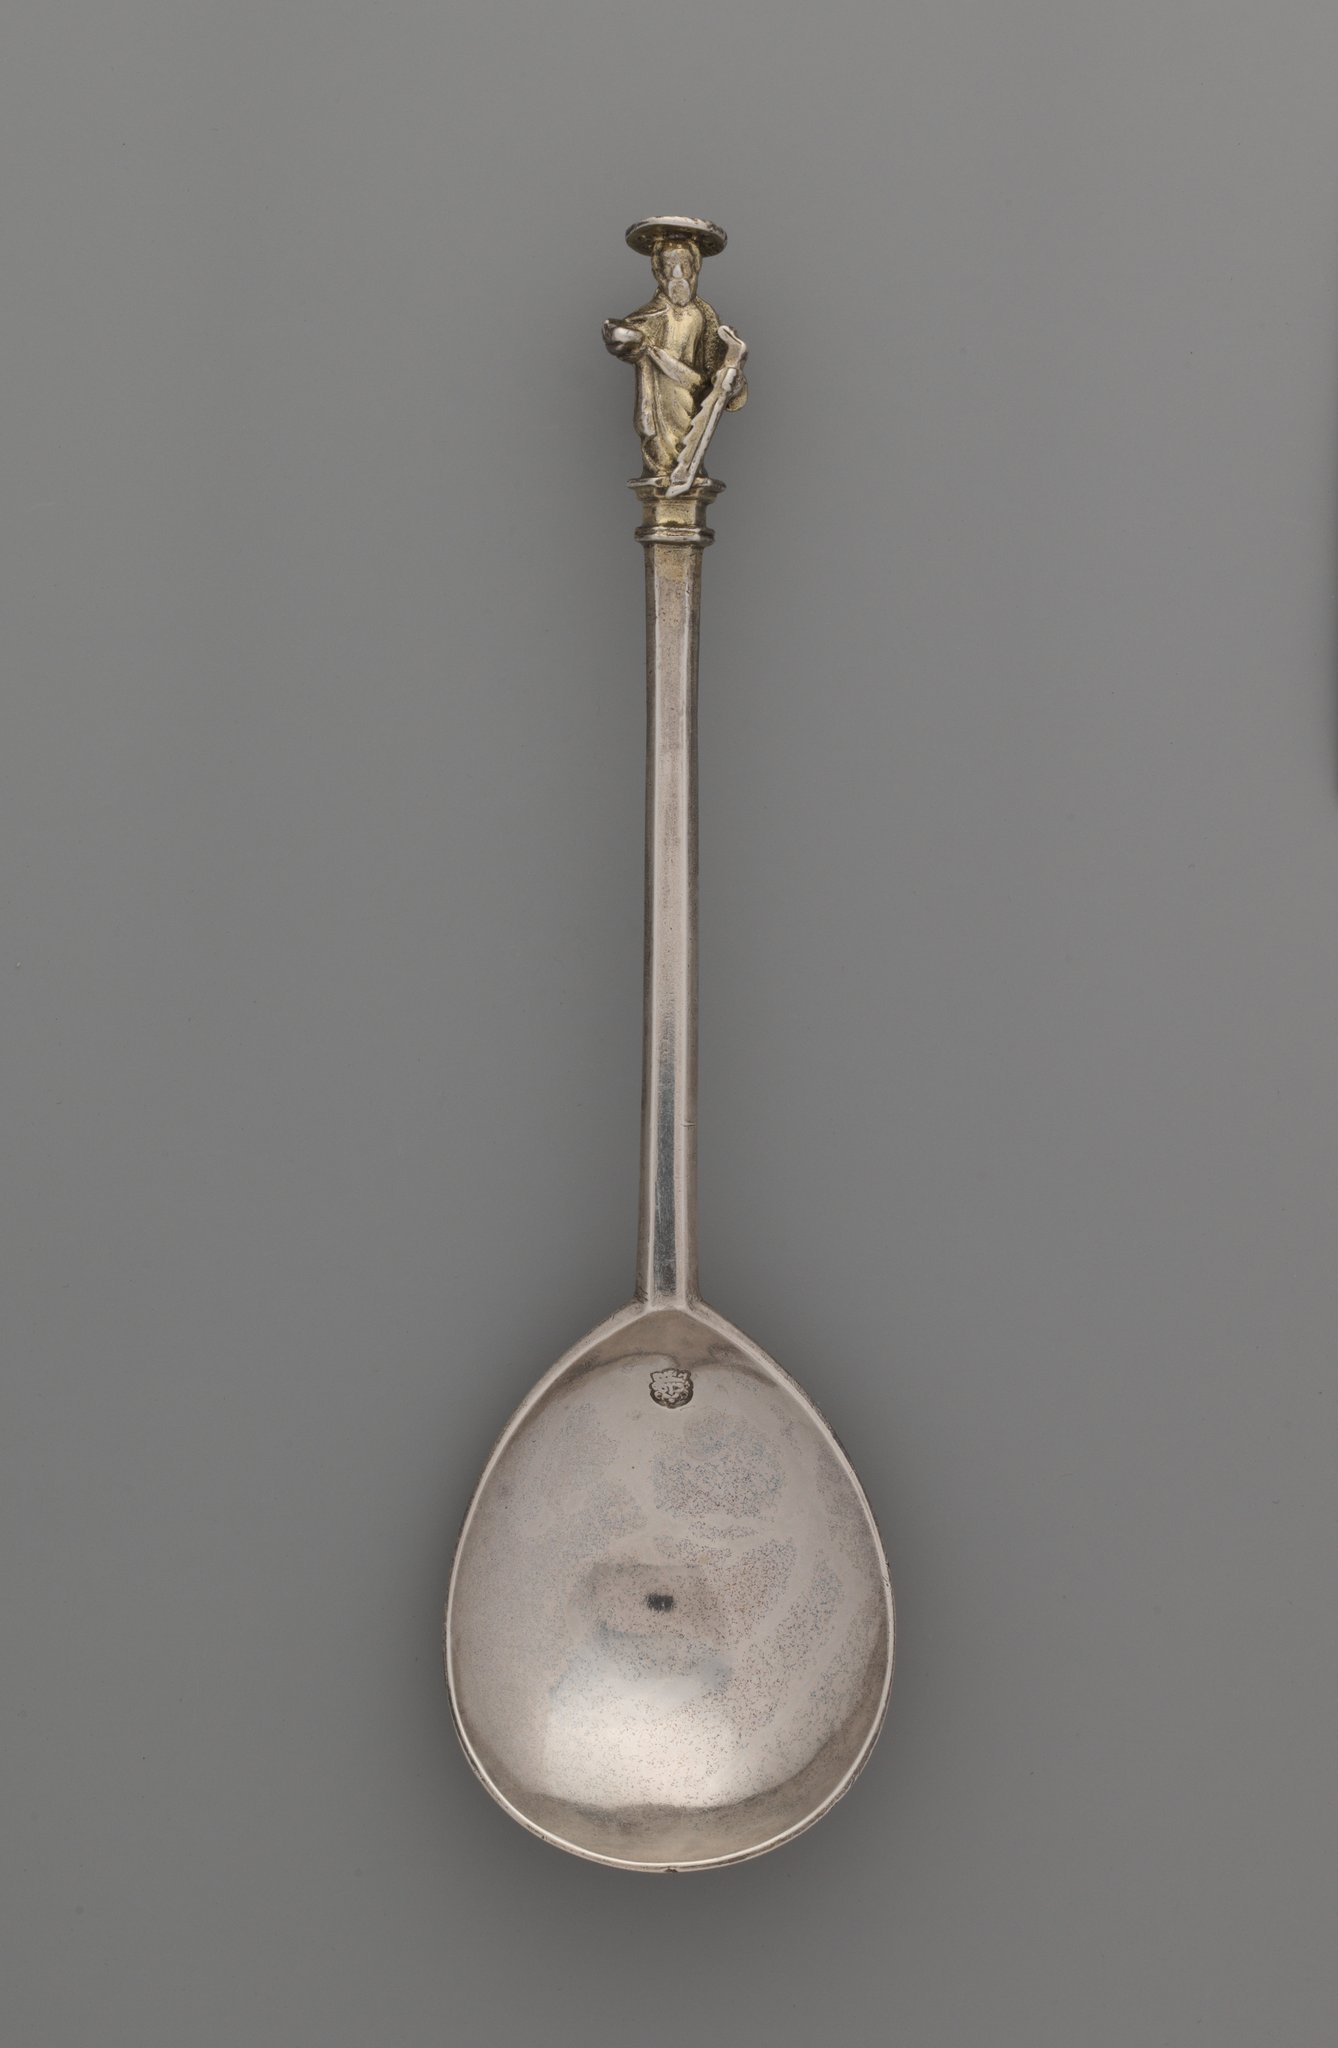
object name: apostle spoon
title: Apostle spoon: St. Simon Zelotes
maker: william cawdell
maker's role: maker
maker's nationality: british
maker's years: 1560-1625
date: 1592-1593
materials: silver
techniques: gilding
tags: apostles